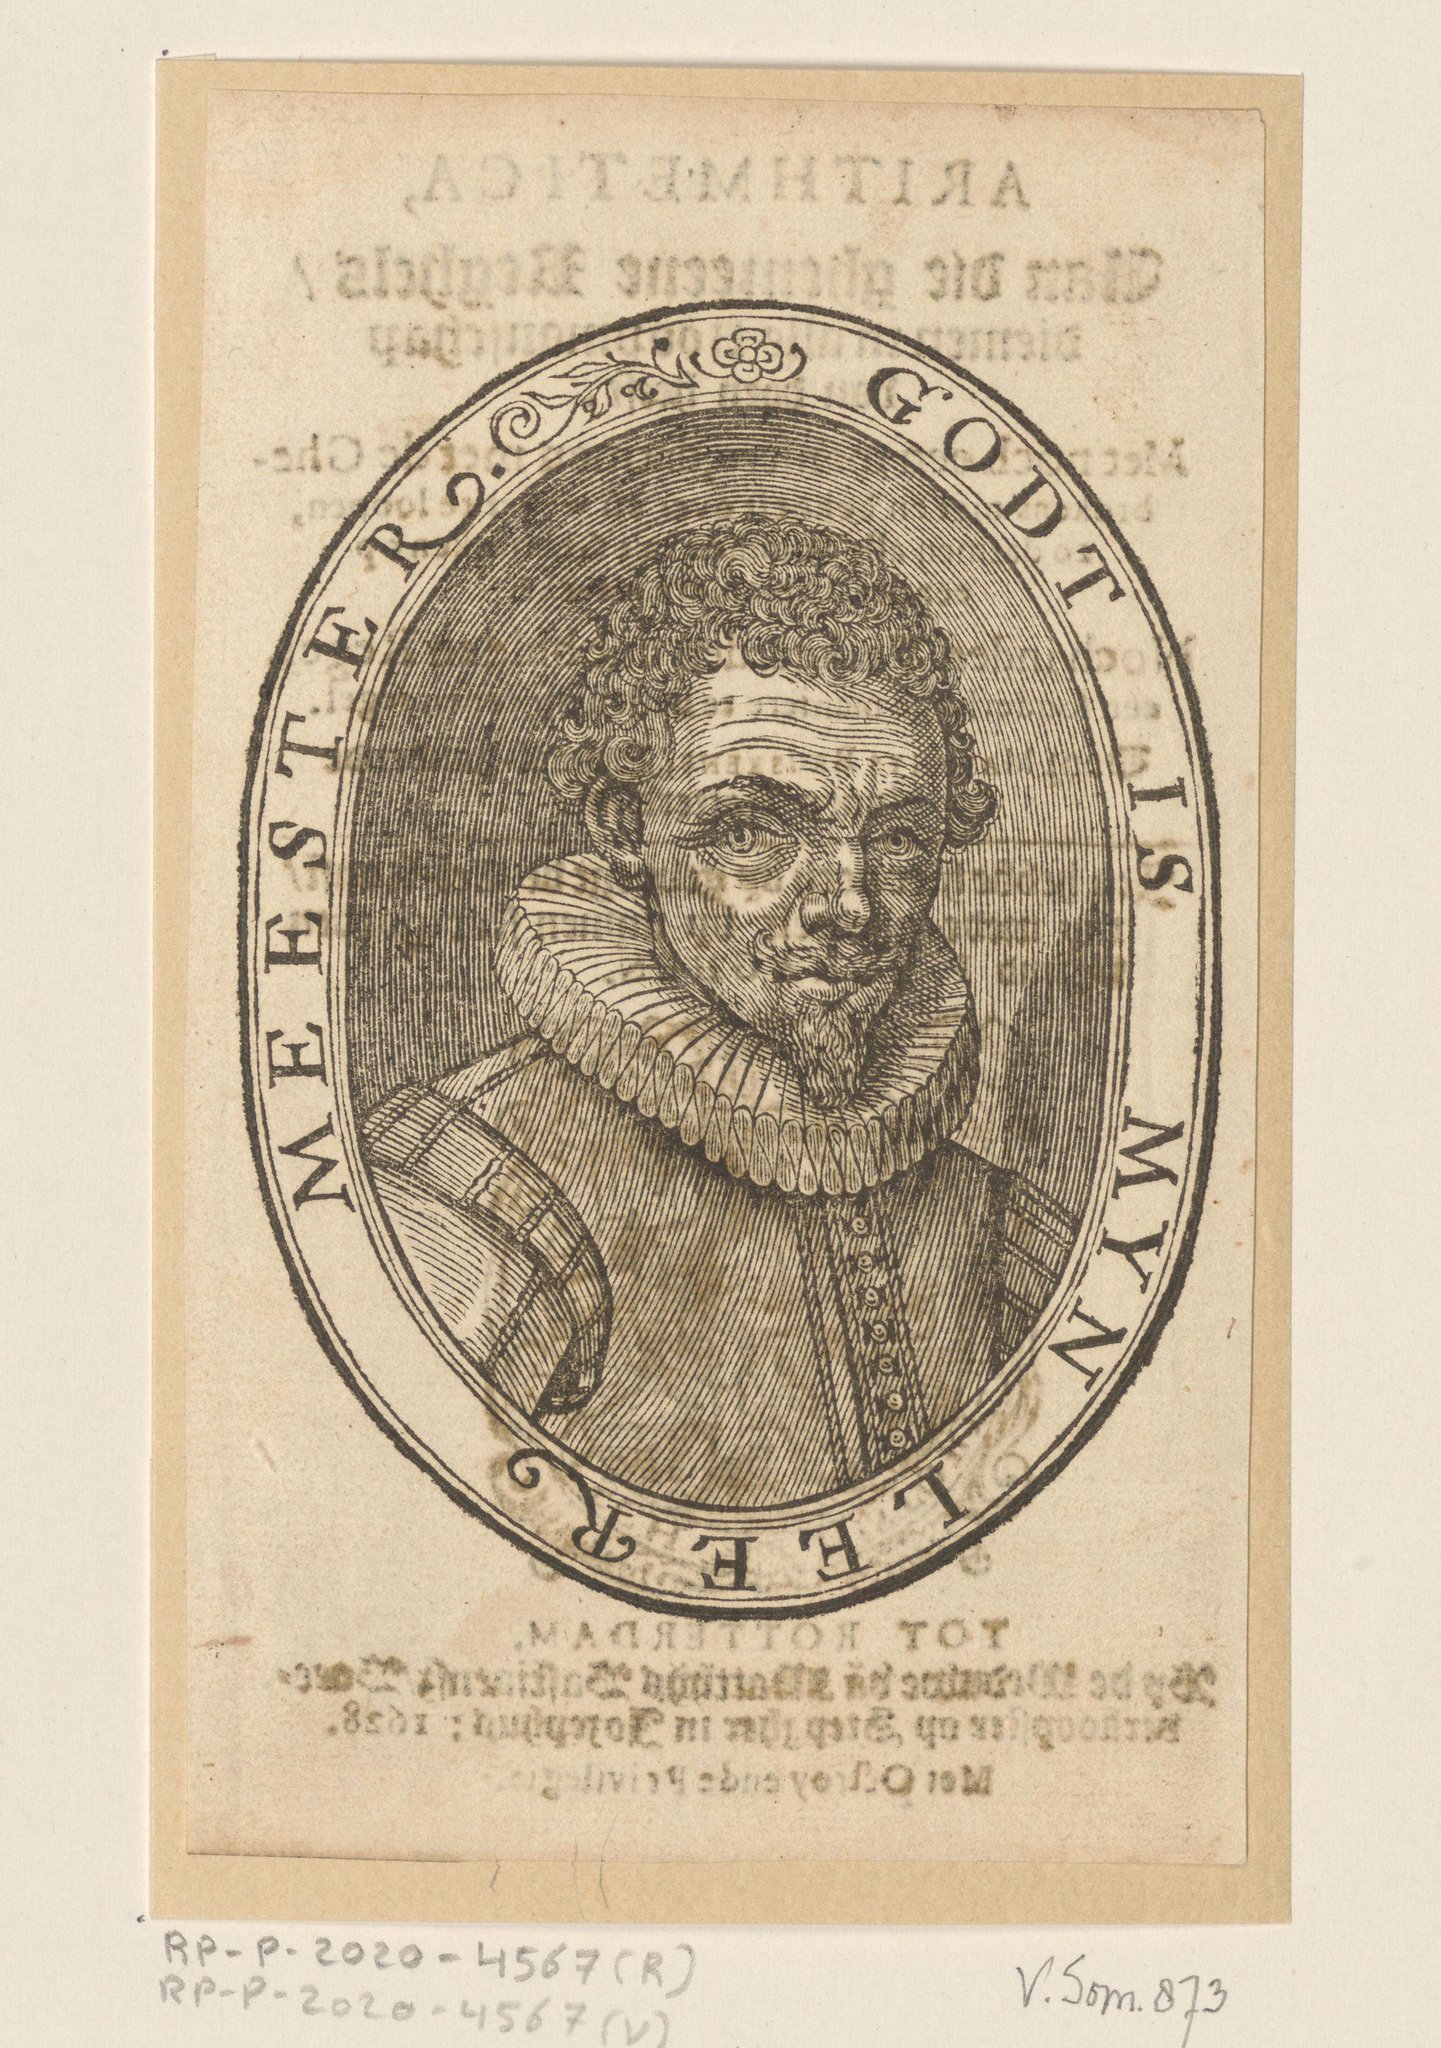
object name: print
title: Portret van Matthys Bruskens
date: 1628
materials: paper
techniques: woodcut, pasting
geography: rotterdam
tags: education, science and learning, historical persons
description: Prent uit: Bruskens, Matthys. Arithmetica, van die ghemeene reghels, diemen in alle koopmanschap van doen heeft. Rotterdam: weduwe Matthijs Bastiaensz., 1628.